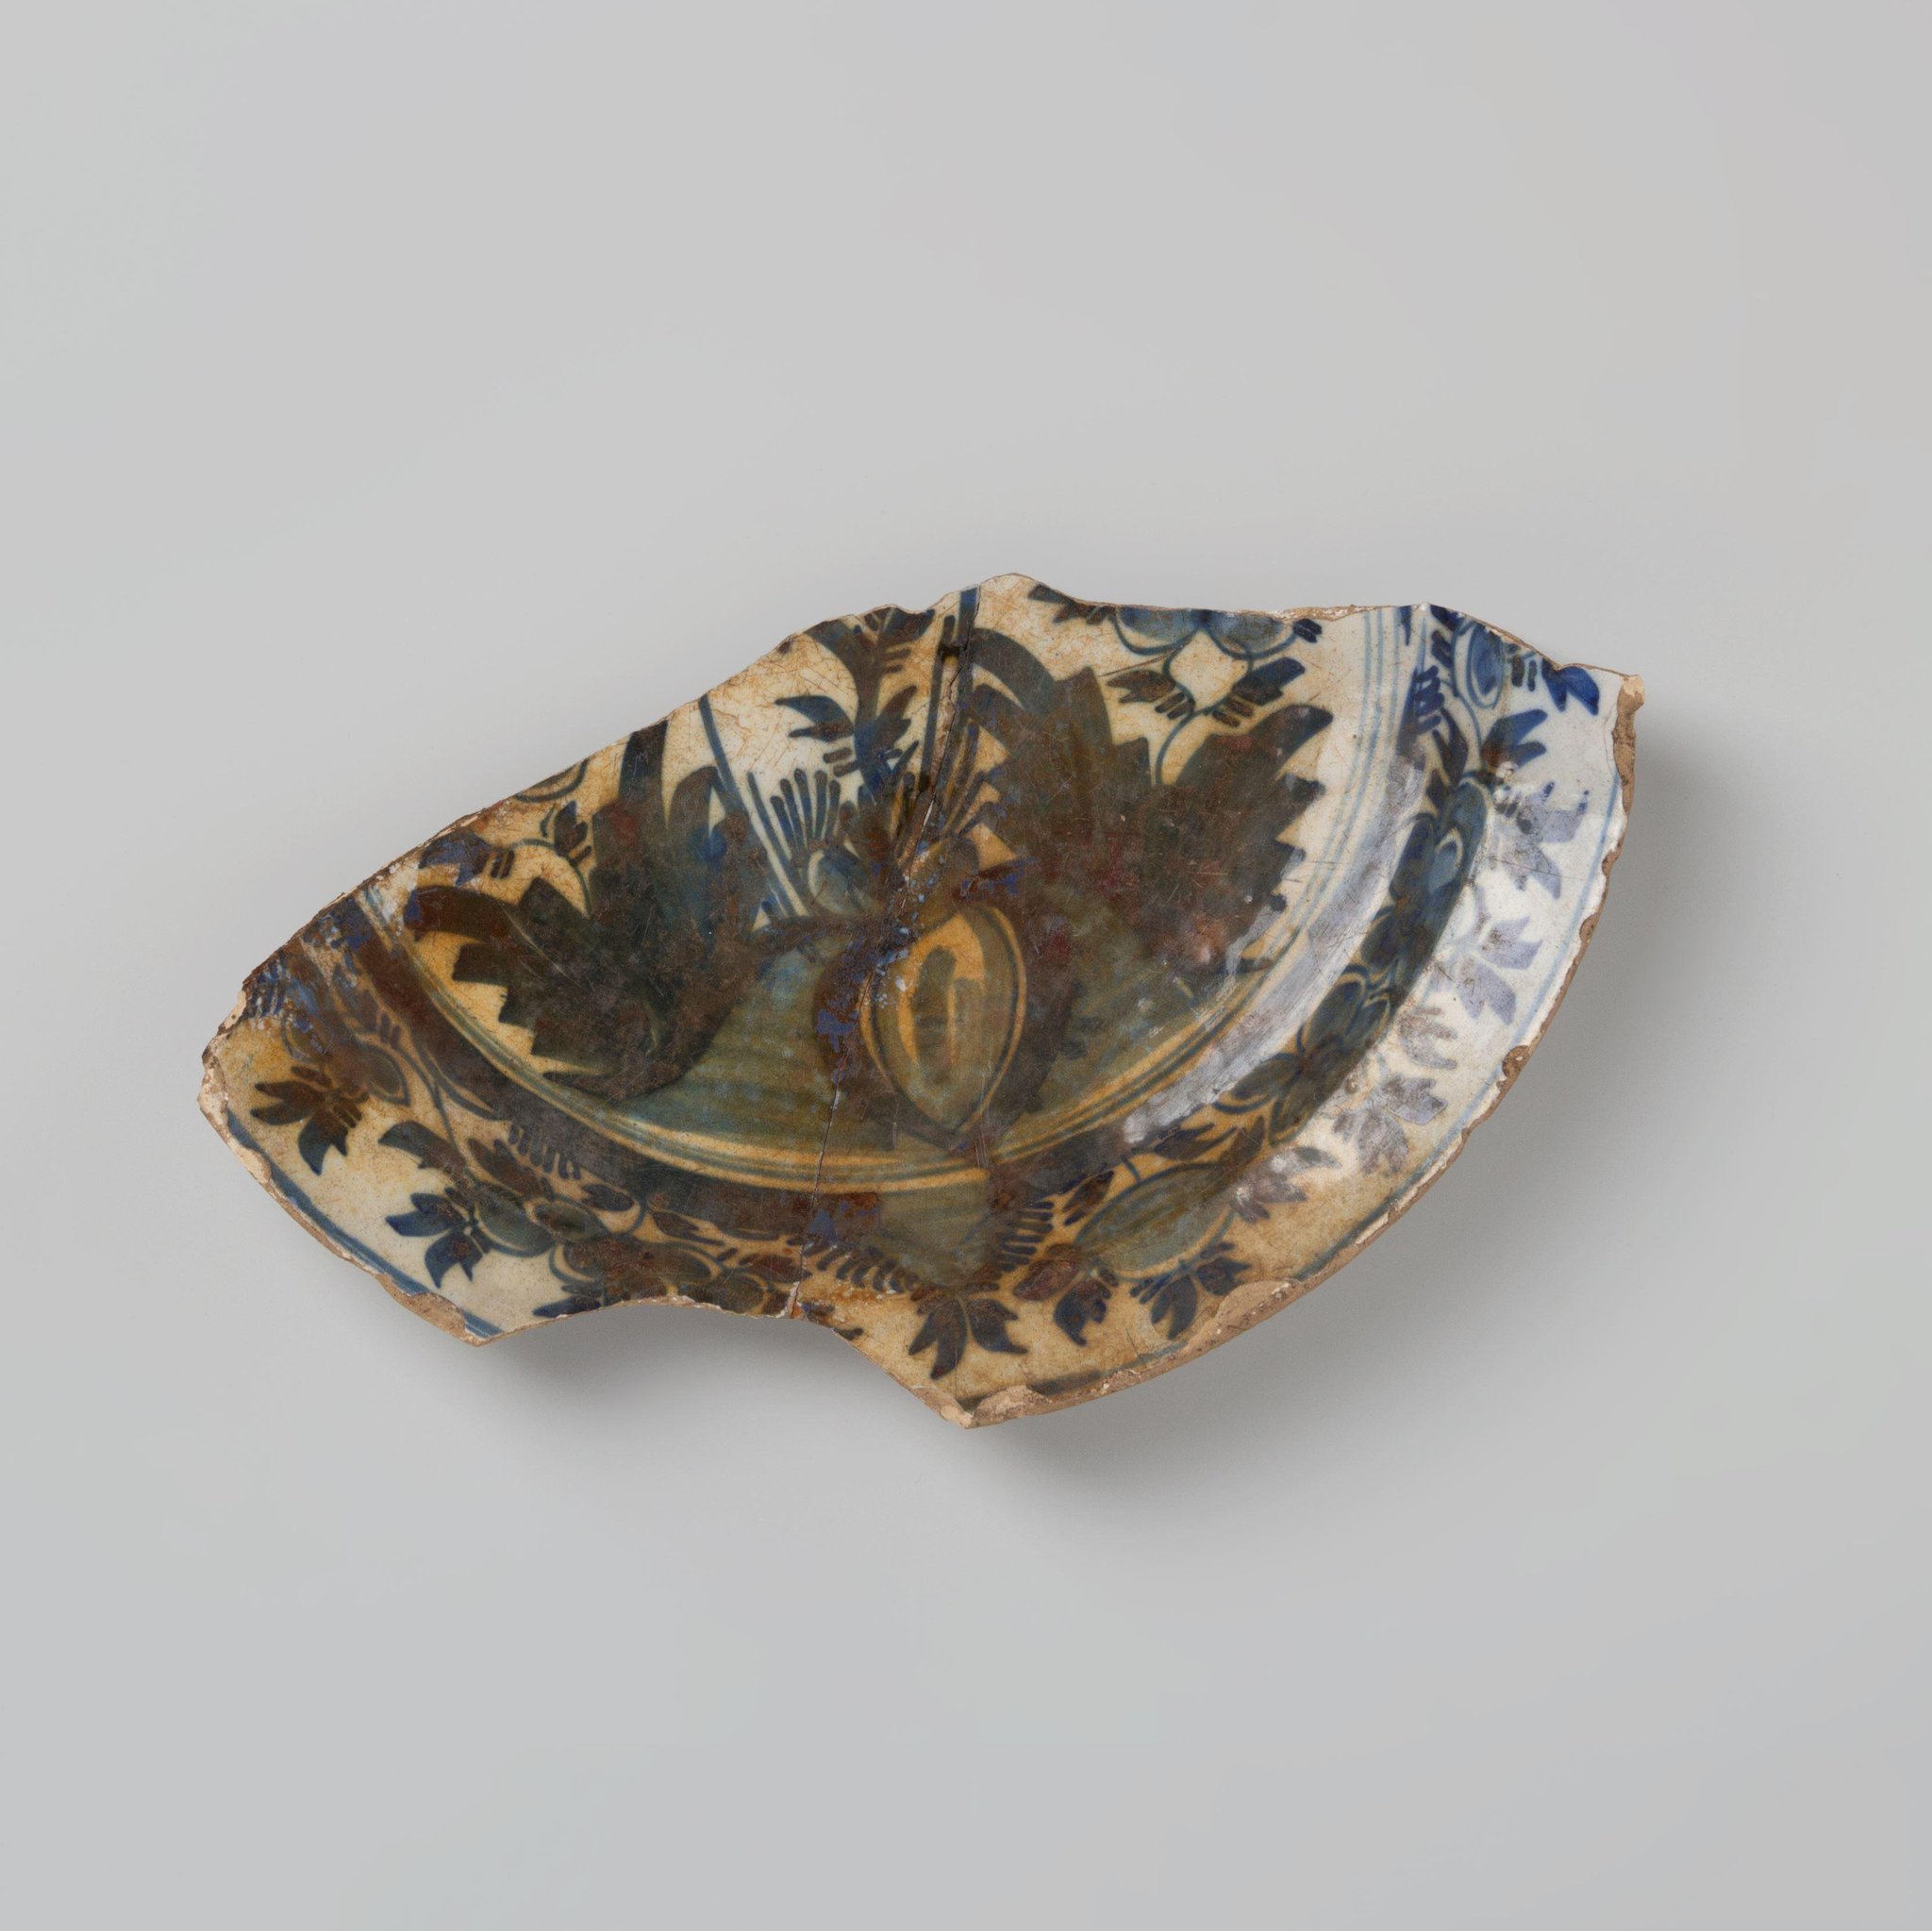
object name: sherd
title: Schotelscherf van aardewerk, voorzien van wit tinglazuur aan de boven- en onderzijde en een voorstelling met bloemen in blauw aan de bovenzijde, beschadigd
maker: Anonymous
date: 1500-1799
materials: earthenware, glaze